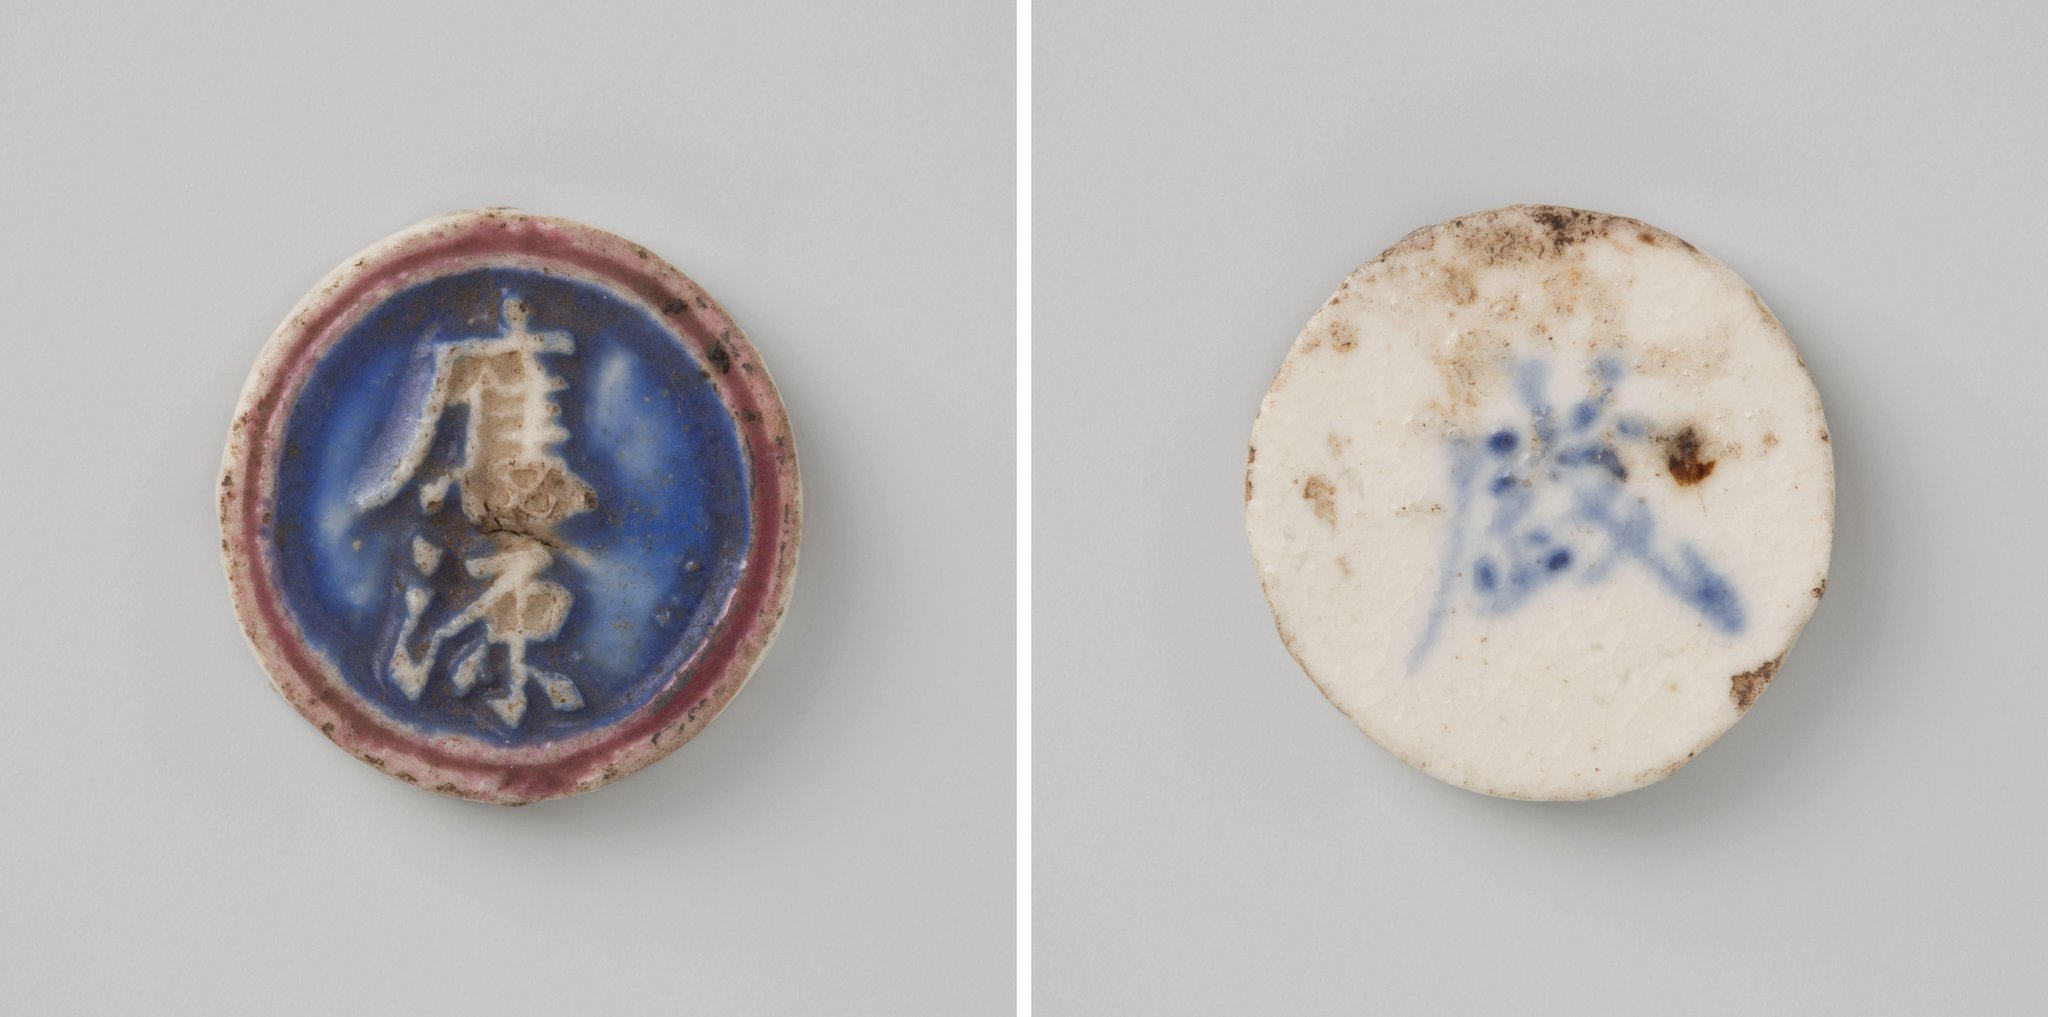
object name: coin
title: Speelhuispenning uit Thailand ter waarde van een salung, 1760-1871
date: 1760-1871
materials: porcelain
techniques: firing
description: Ronde porseleinen speelhuispenning, die ook als munt is gebruikt. Voorzijde: twee Chinese karakters. Keerzijde:een Chinees karakter.